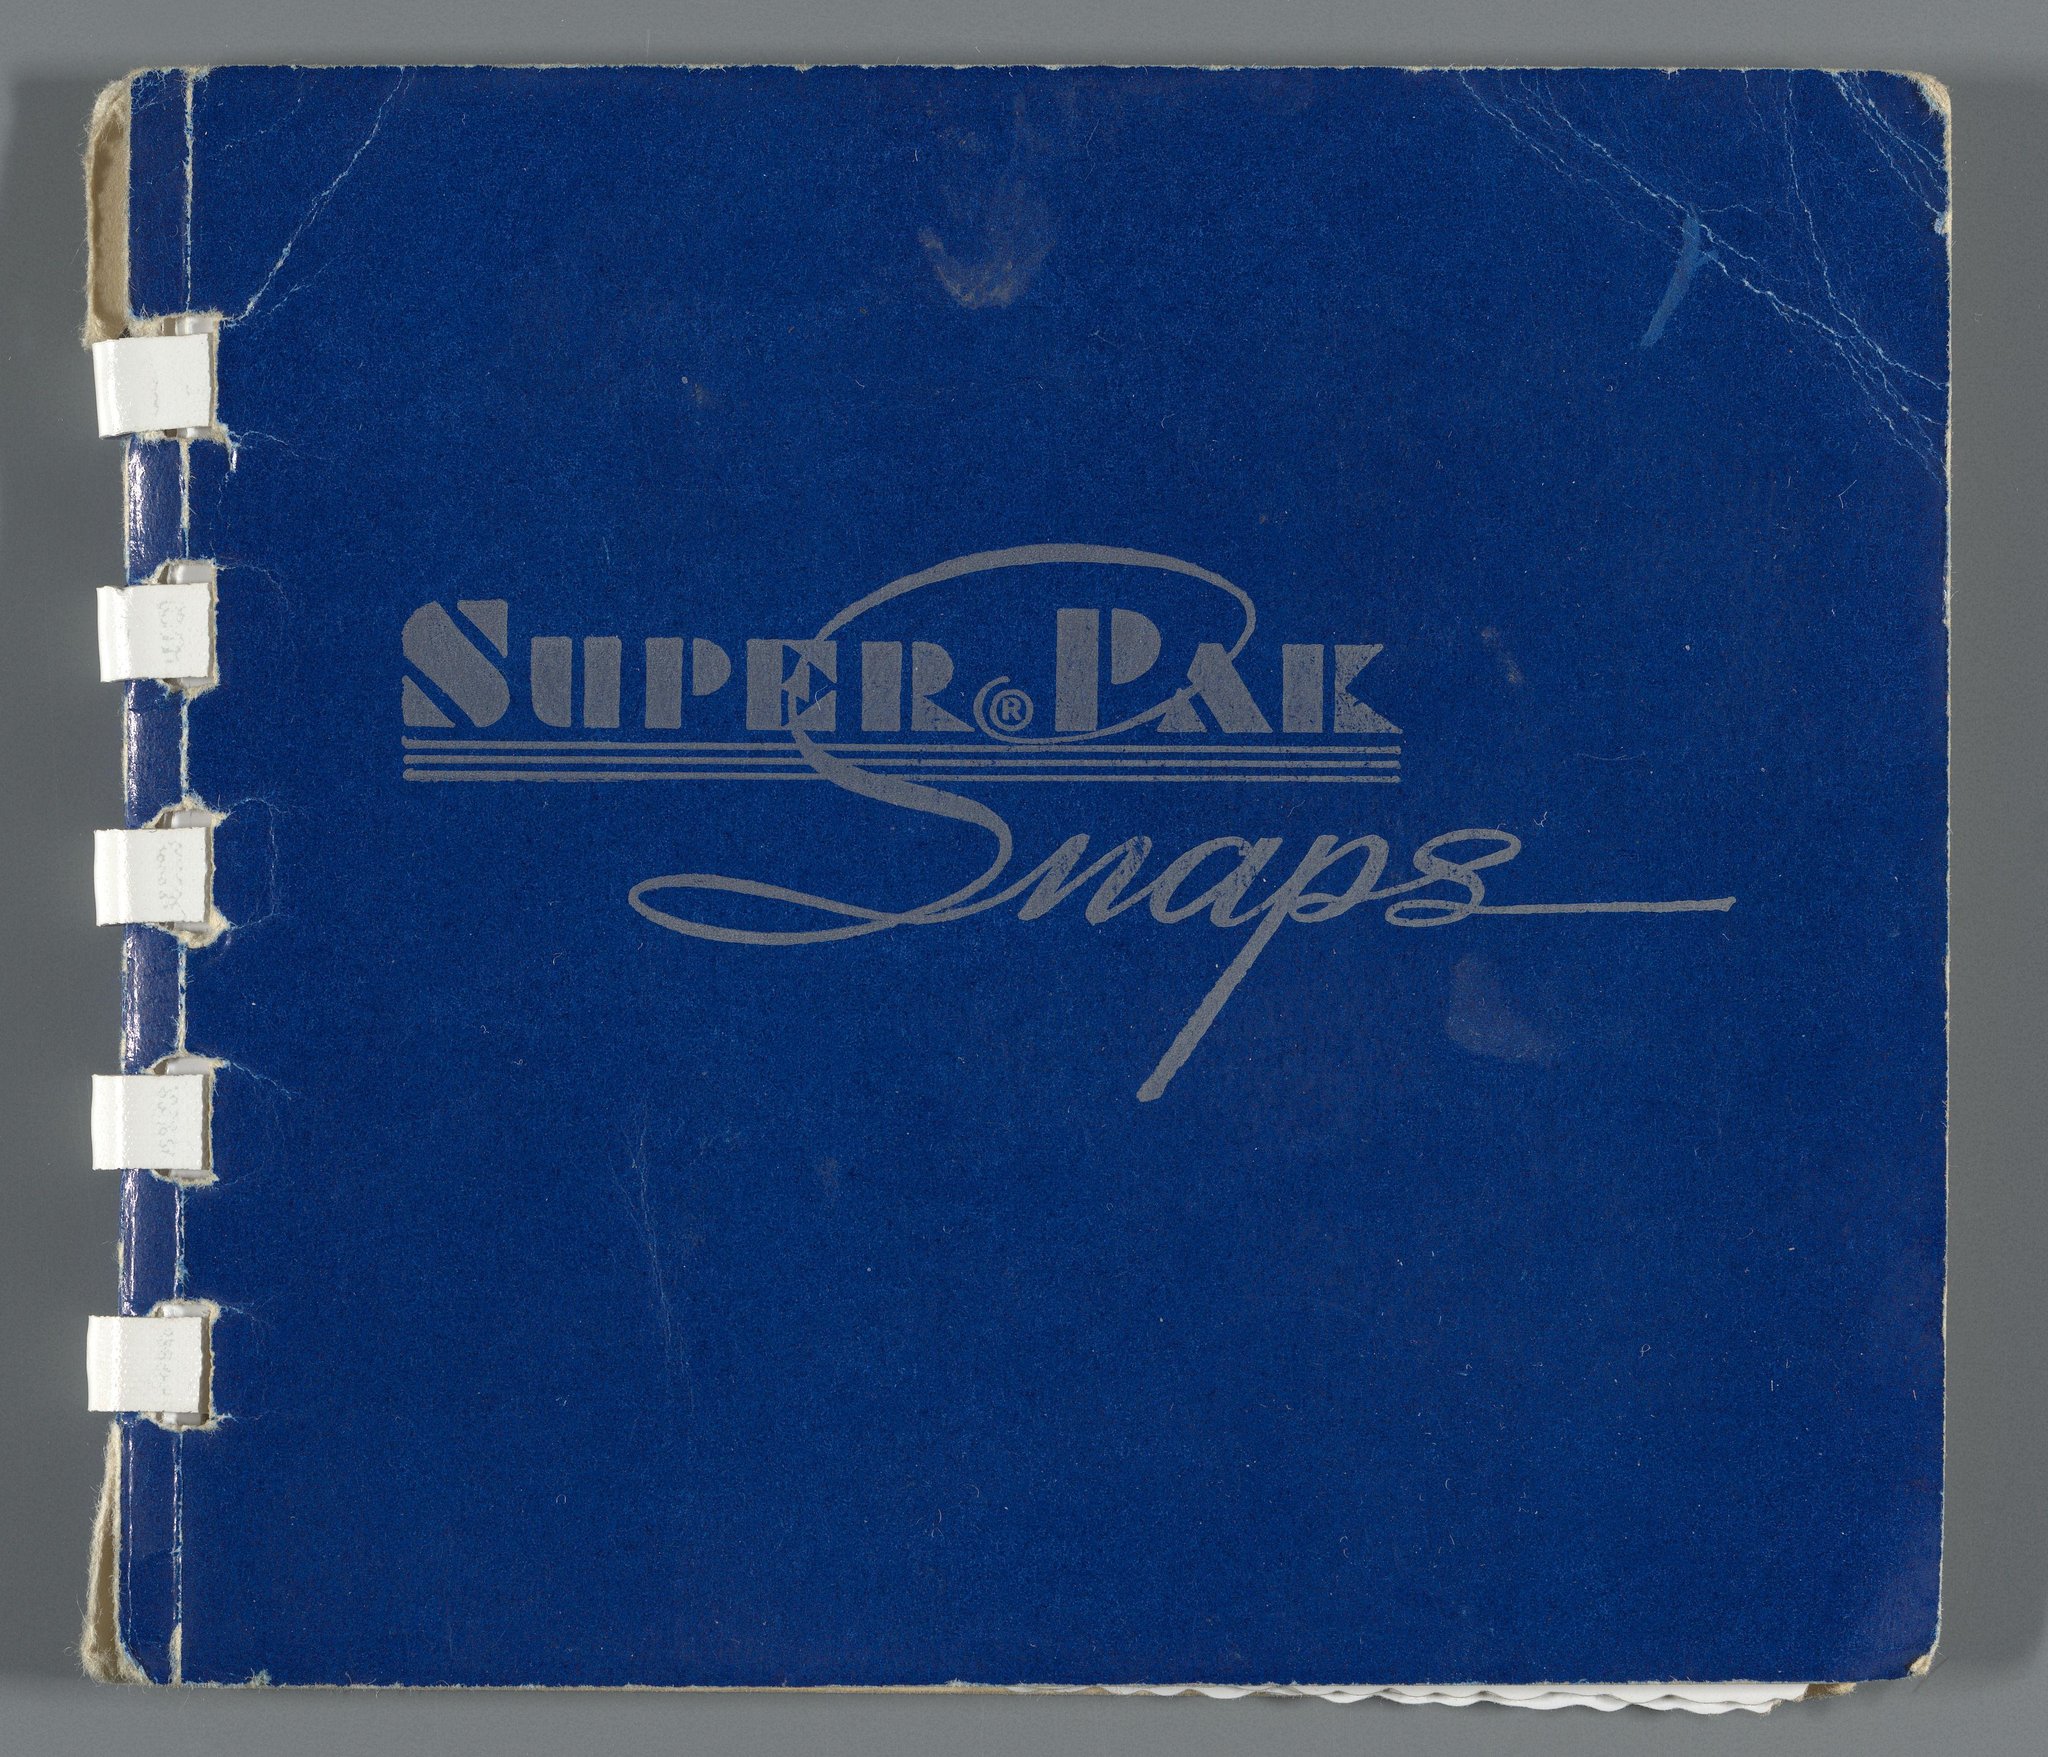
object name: photograph album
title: Album Super Pak Snaps met 10 Kodak Instamatic-opnamen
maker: Anonymous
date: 1956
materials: photographic support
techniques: gelatin silver print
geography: new york city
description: Groepsportretten, Karmel Hotel Loch Sheldrake N.Y.